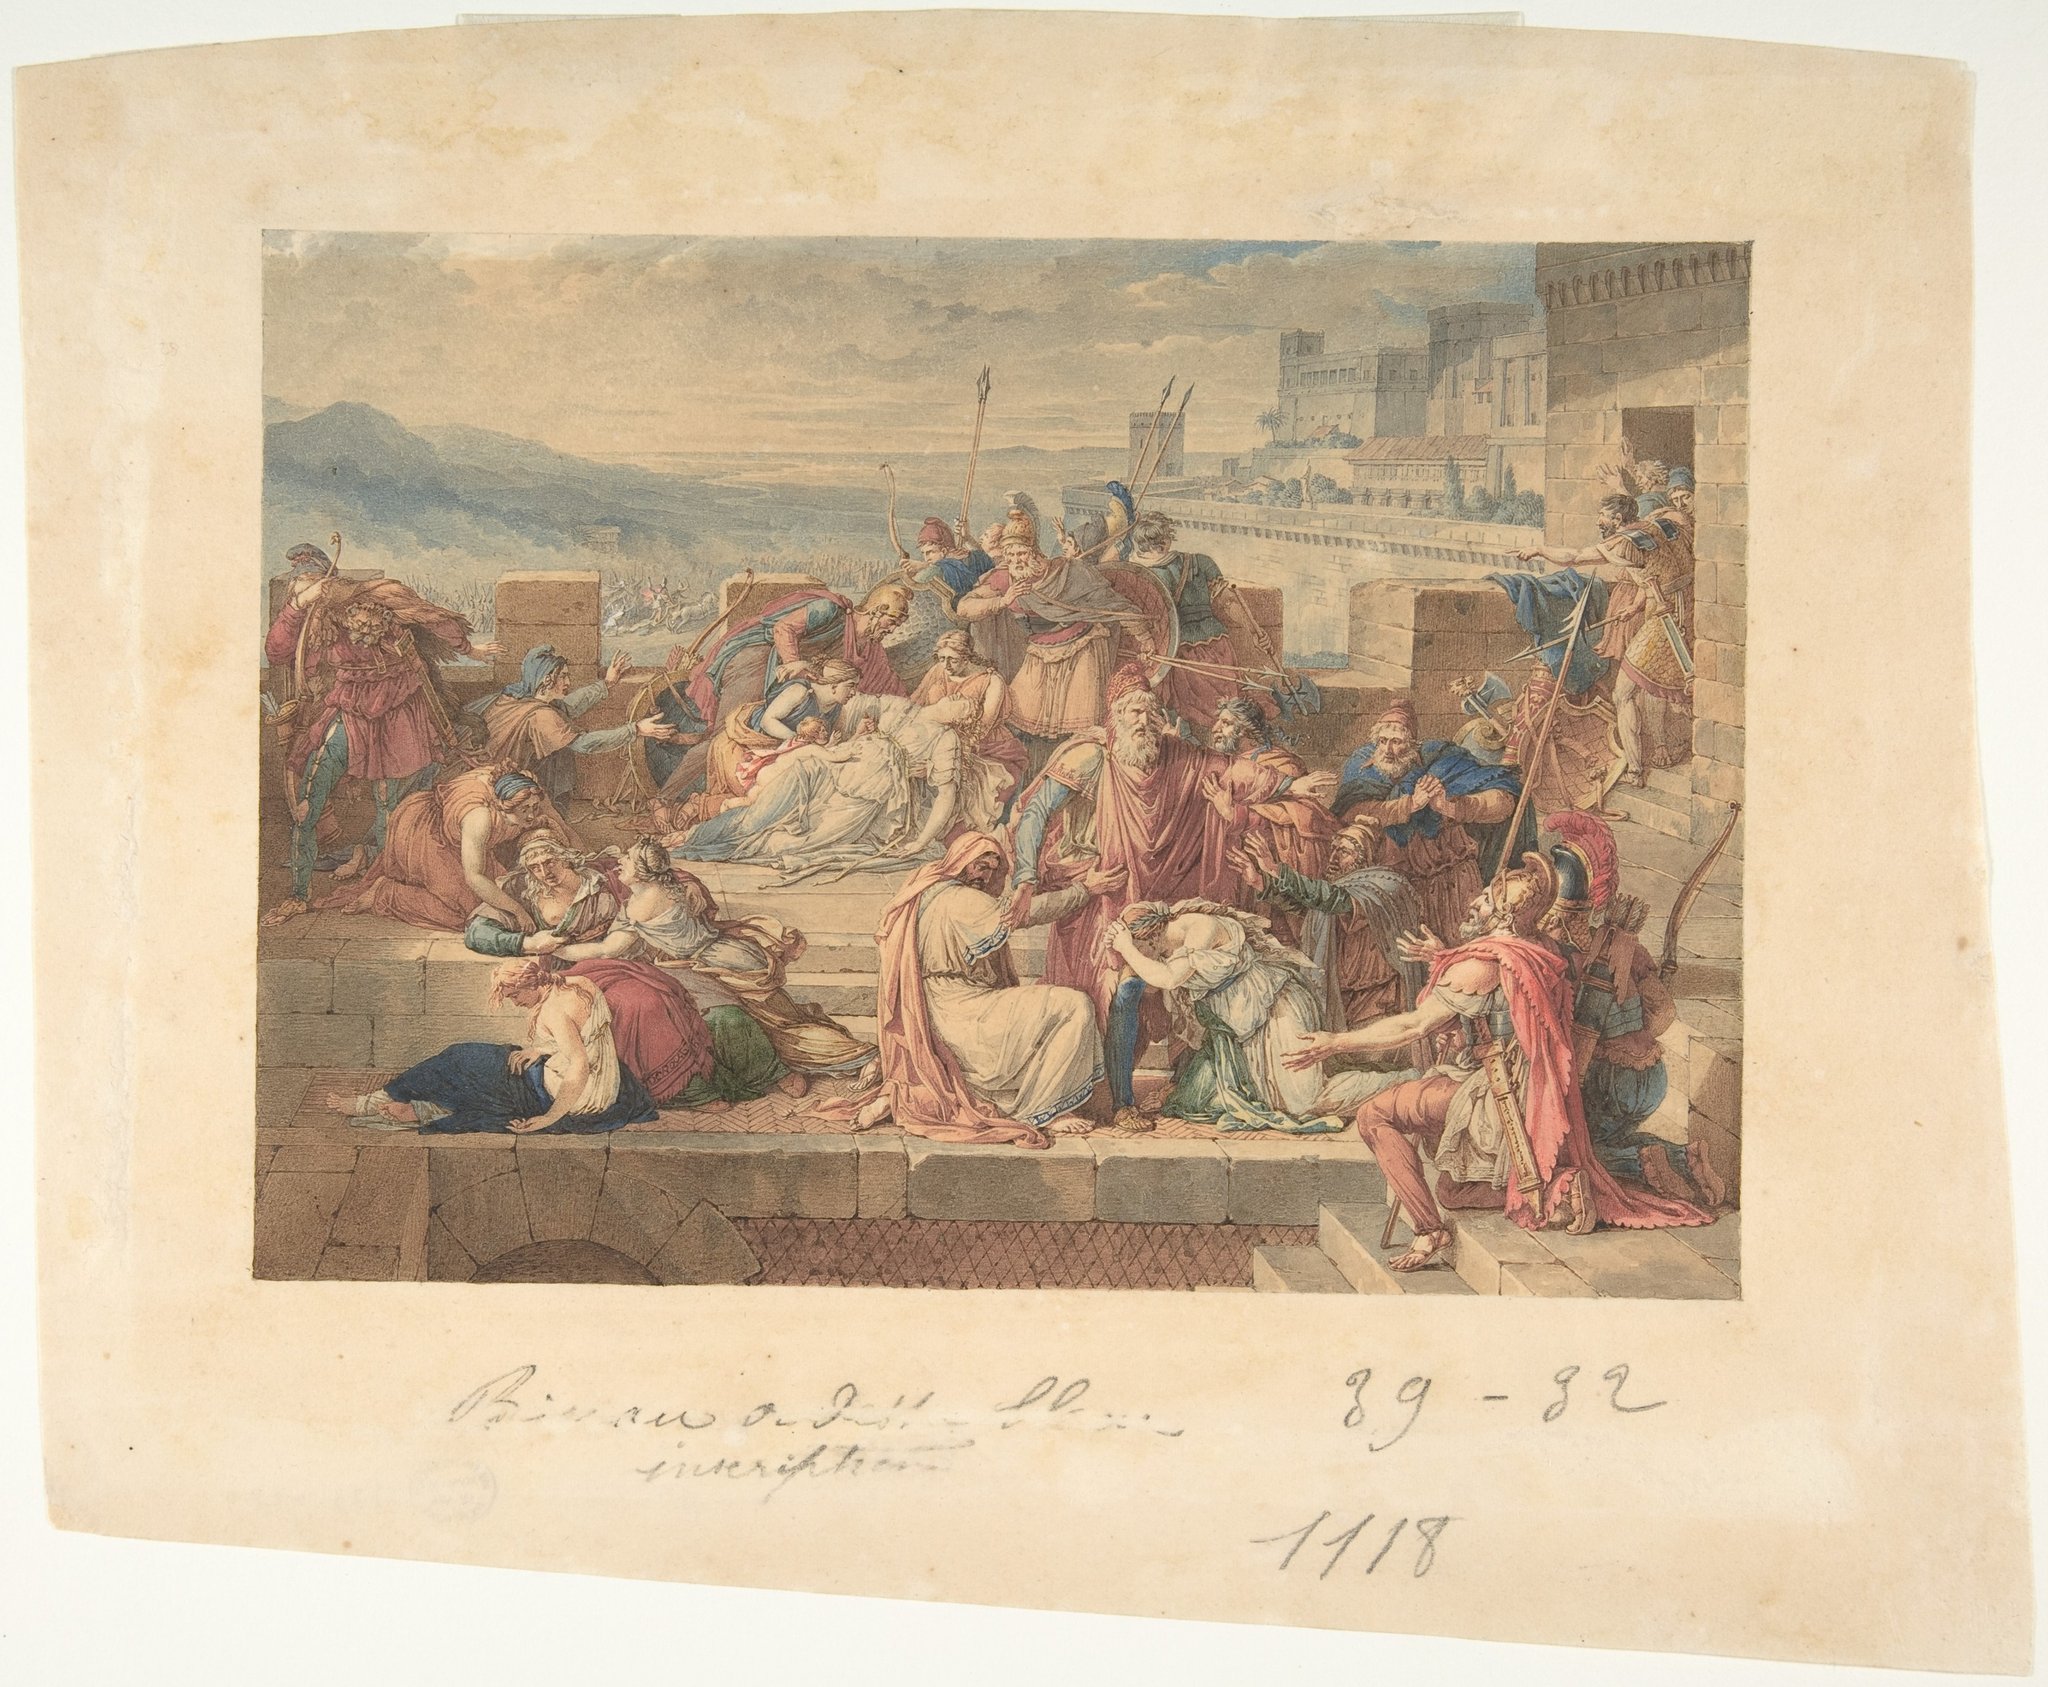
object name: drawing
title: Priam and his Family Mourning the Death of Hector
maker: etienne barthélemy garnier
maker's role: artist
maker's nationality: french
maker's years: 1759-1849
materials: graphite, varnish, watercolor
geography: france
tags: soldiers,kings,princes,sadness,men,women,death,family